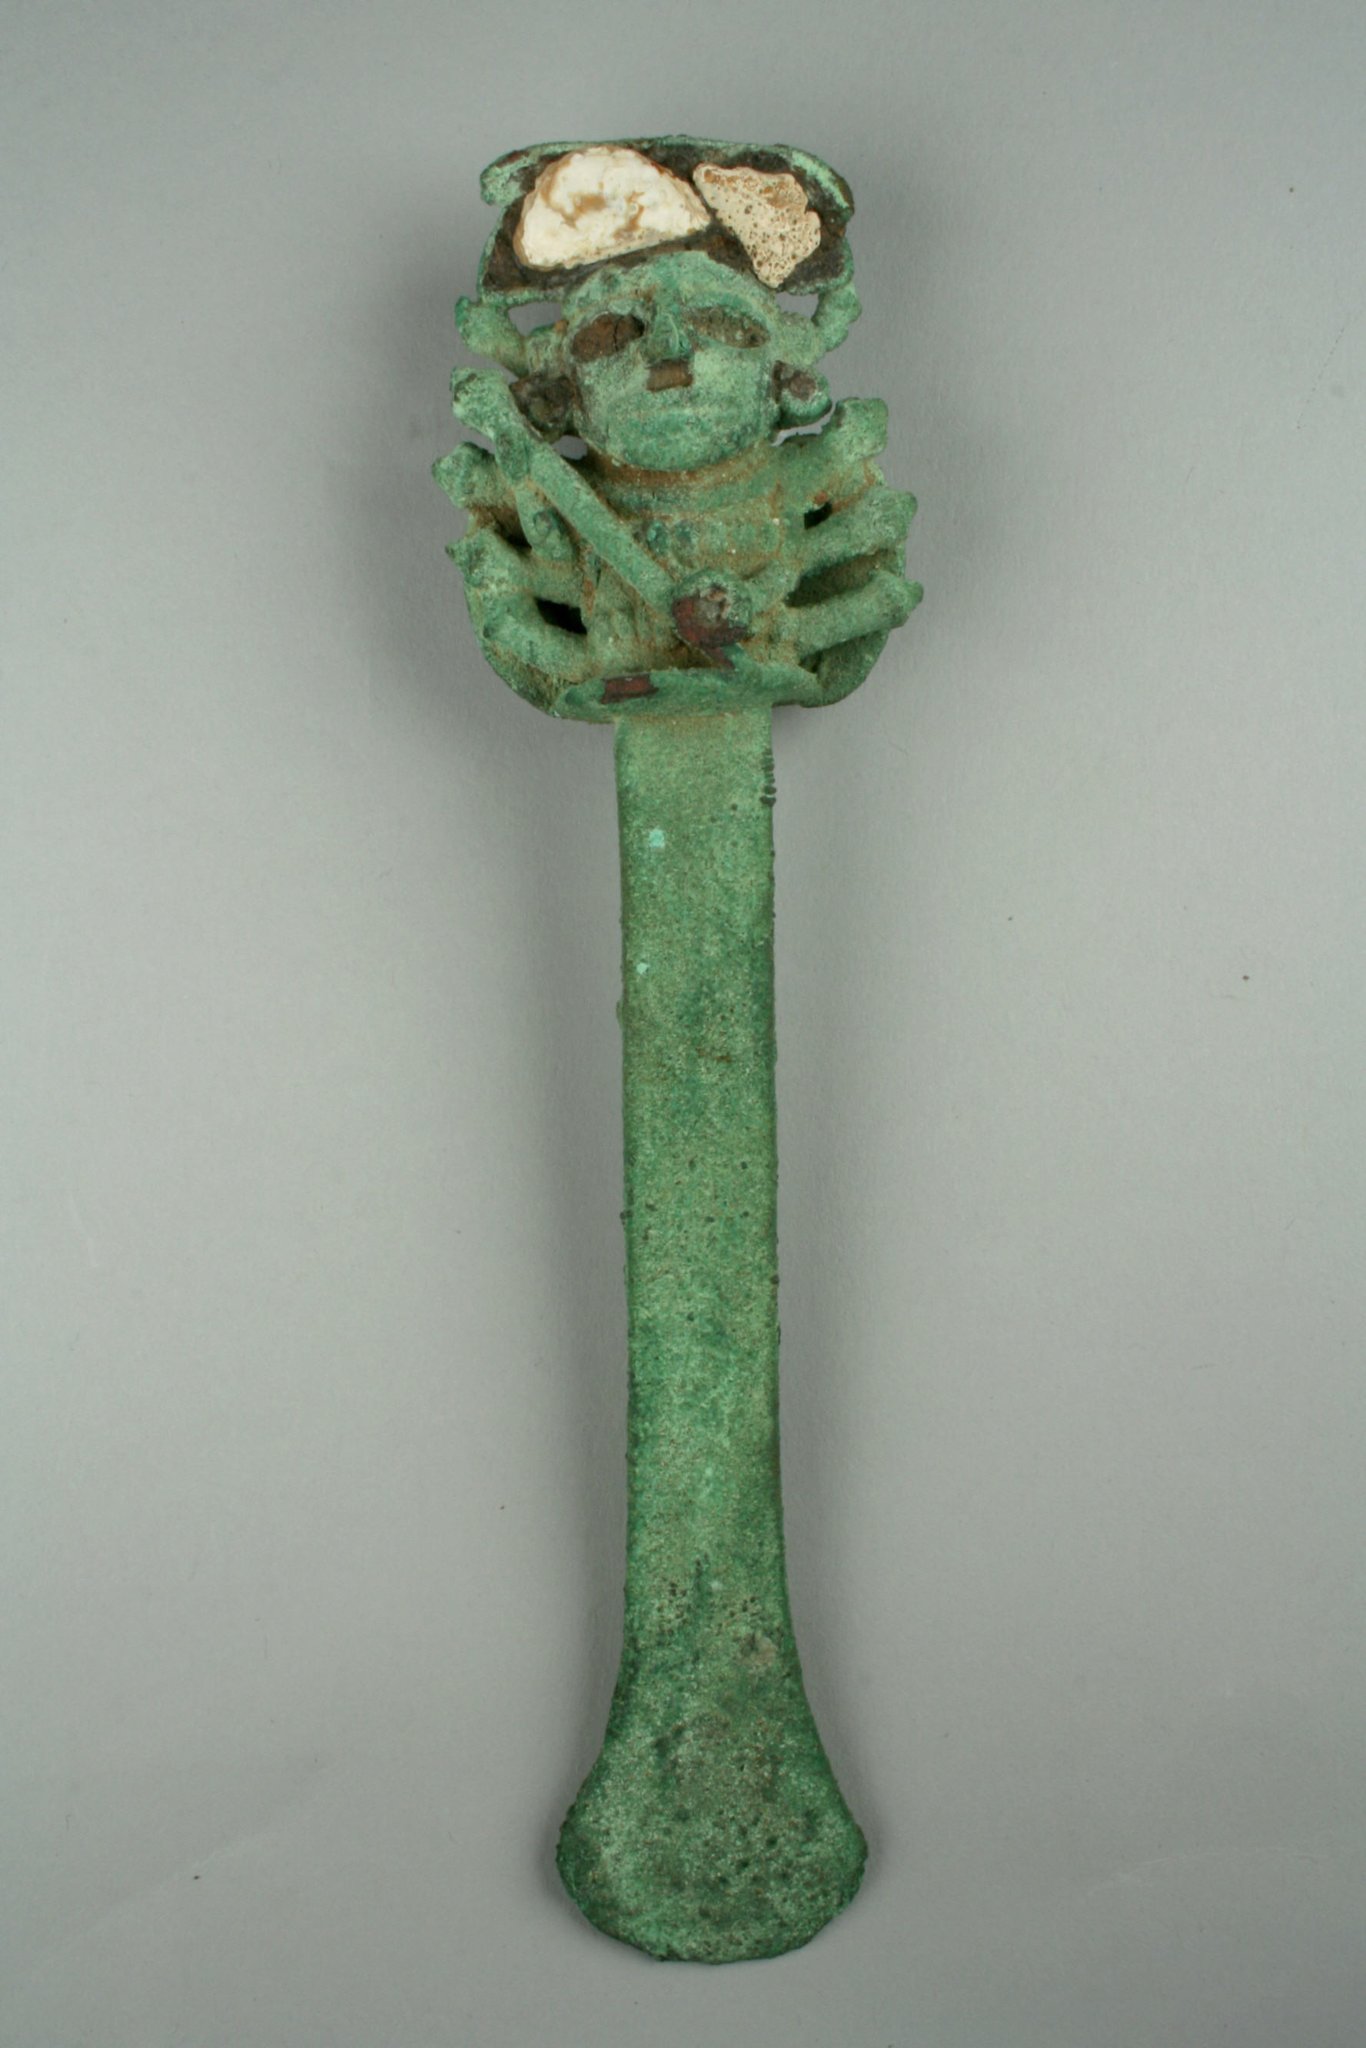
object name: knife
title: Ceremonial Knife (Tumi)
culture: moche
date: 101-700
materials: copper, shell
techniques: casting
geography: peru